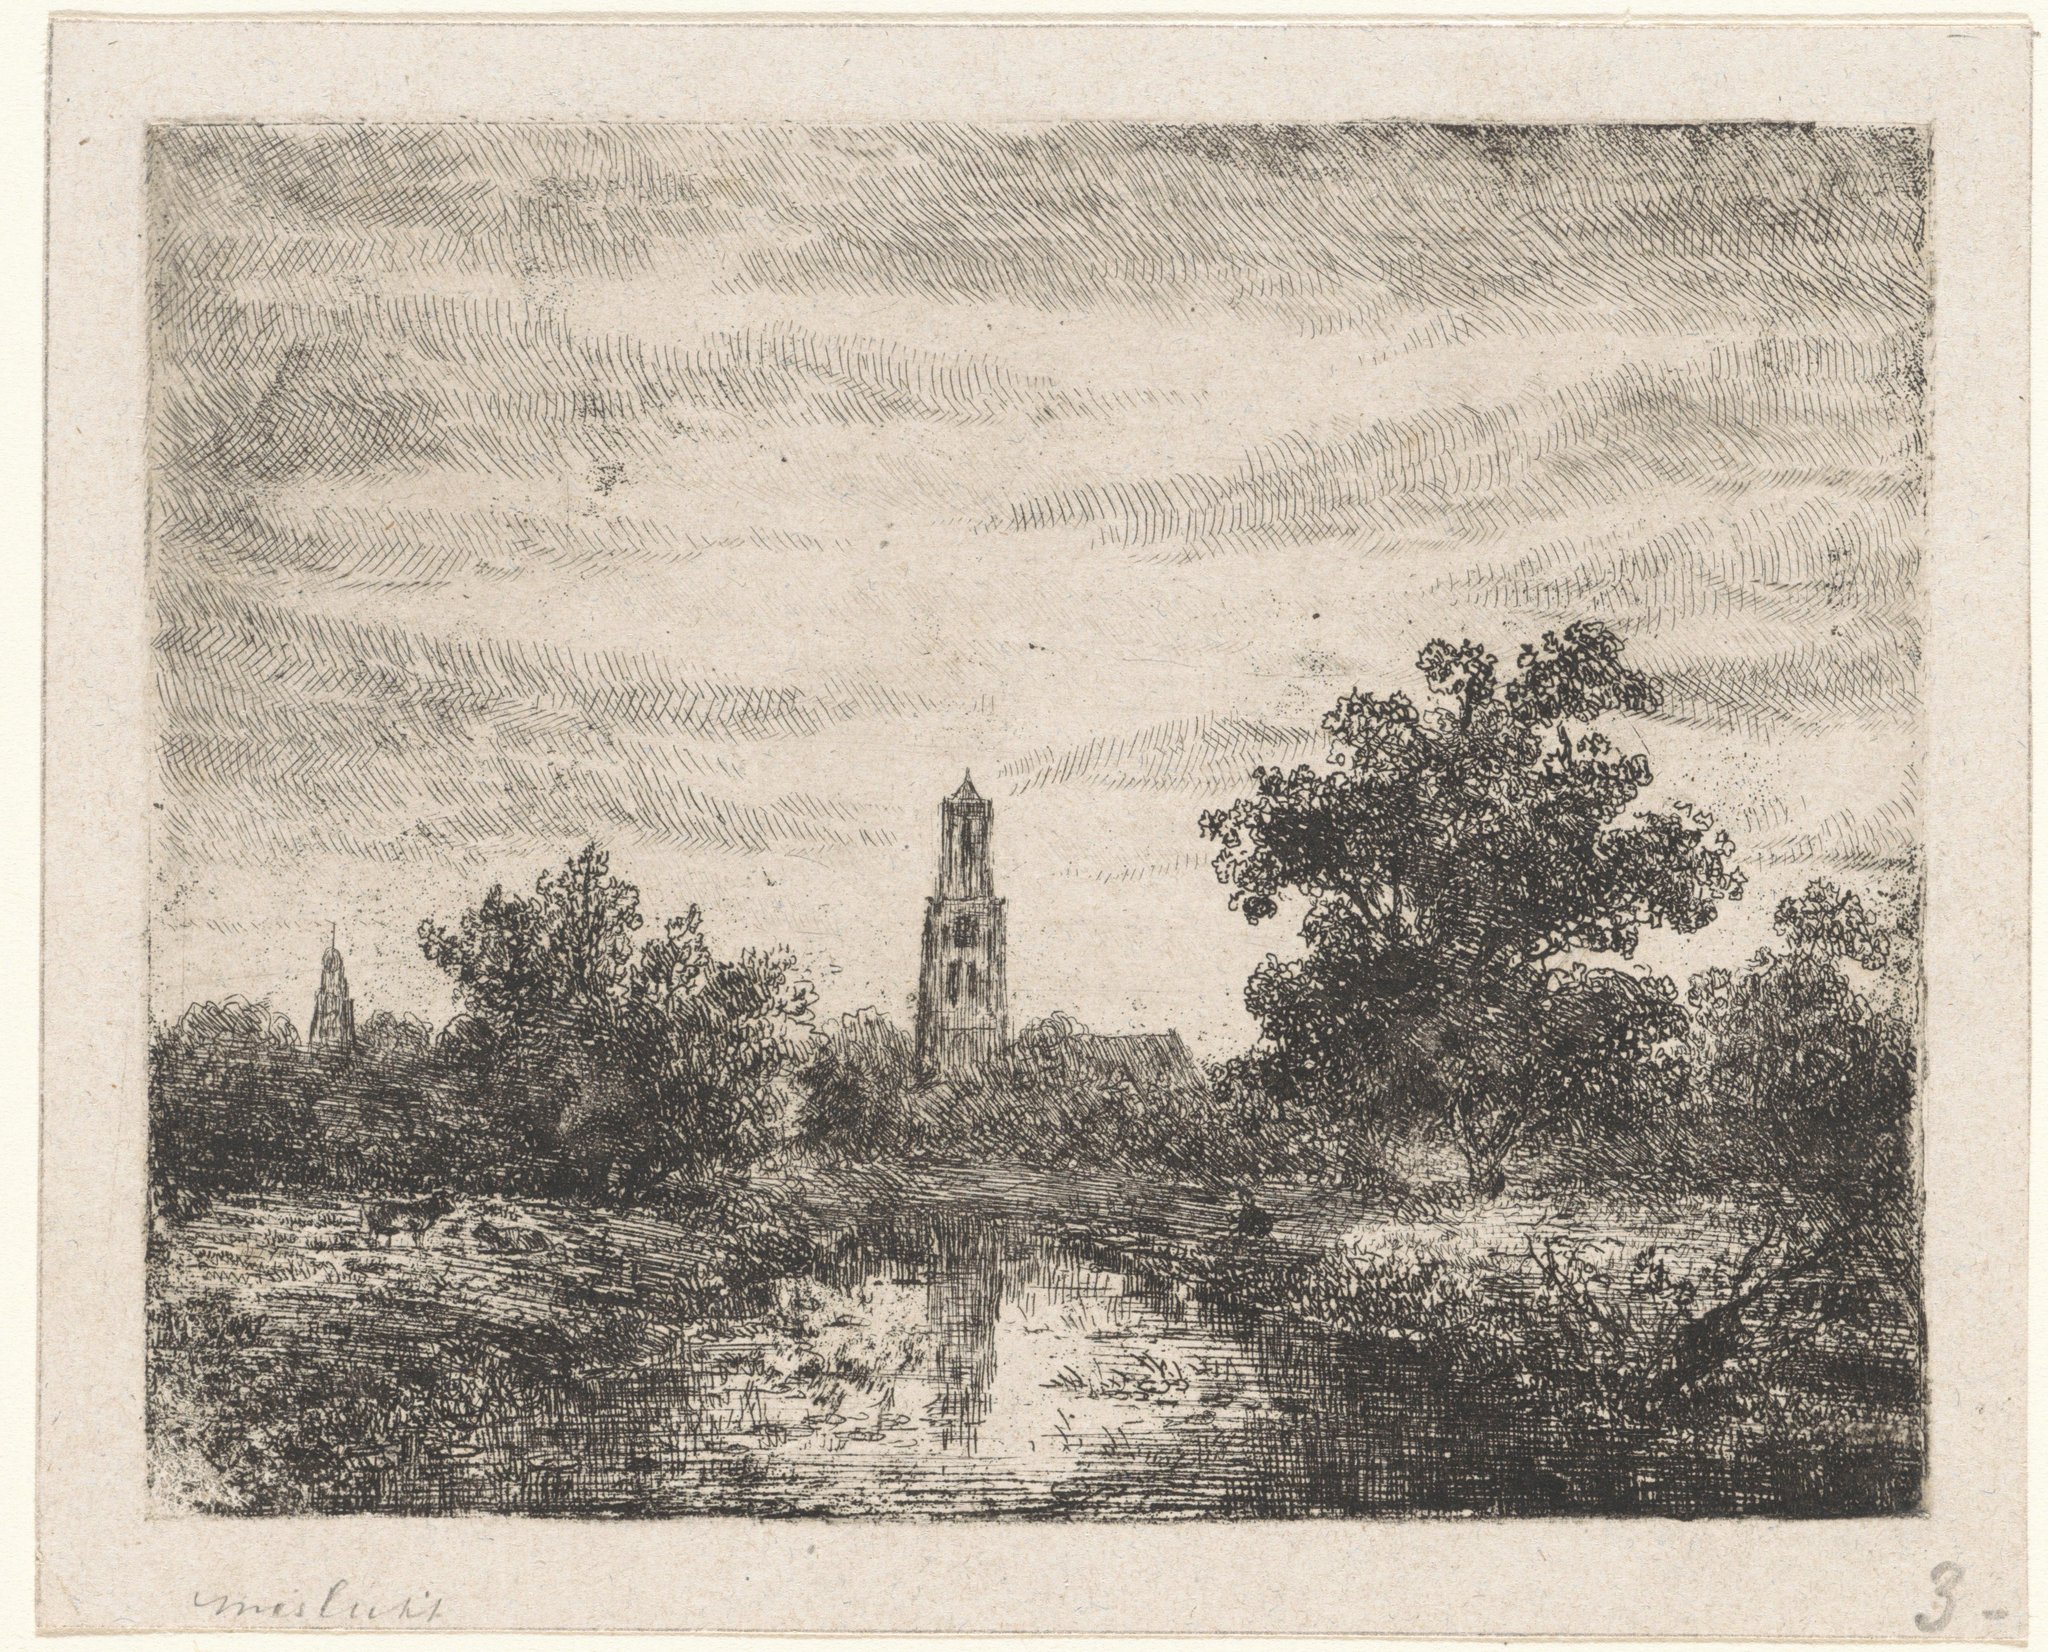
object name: print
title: Gezicht op Utrecht(?)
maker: Anonymous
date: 1830-1882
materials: paper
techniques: etching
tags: city-view, and landscape with man-made constructions, cow, river, fisherman, parts of church exterior and annexes: tower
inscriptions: collector's mark: Lugt 2228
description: Rechts vooraan een visser aan de oever van een rivier. Links twee koeien. In de verte een stadsgezicht, Utrecht(?), met twee torens.